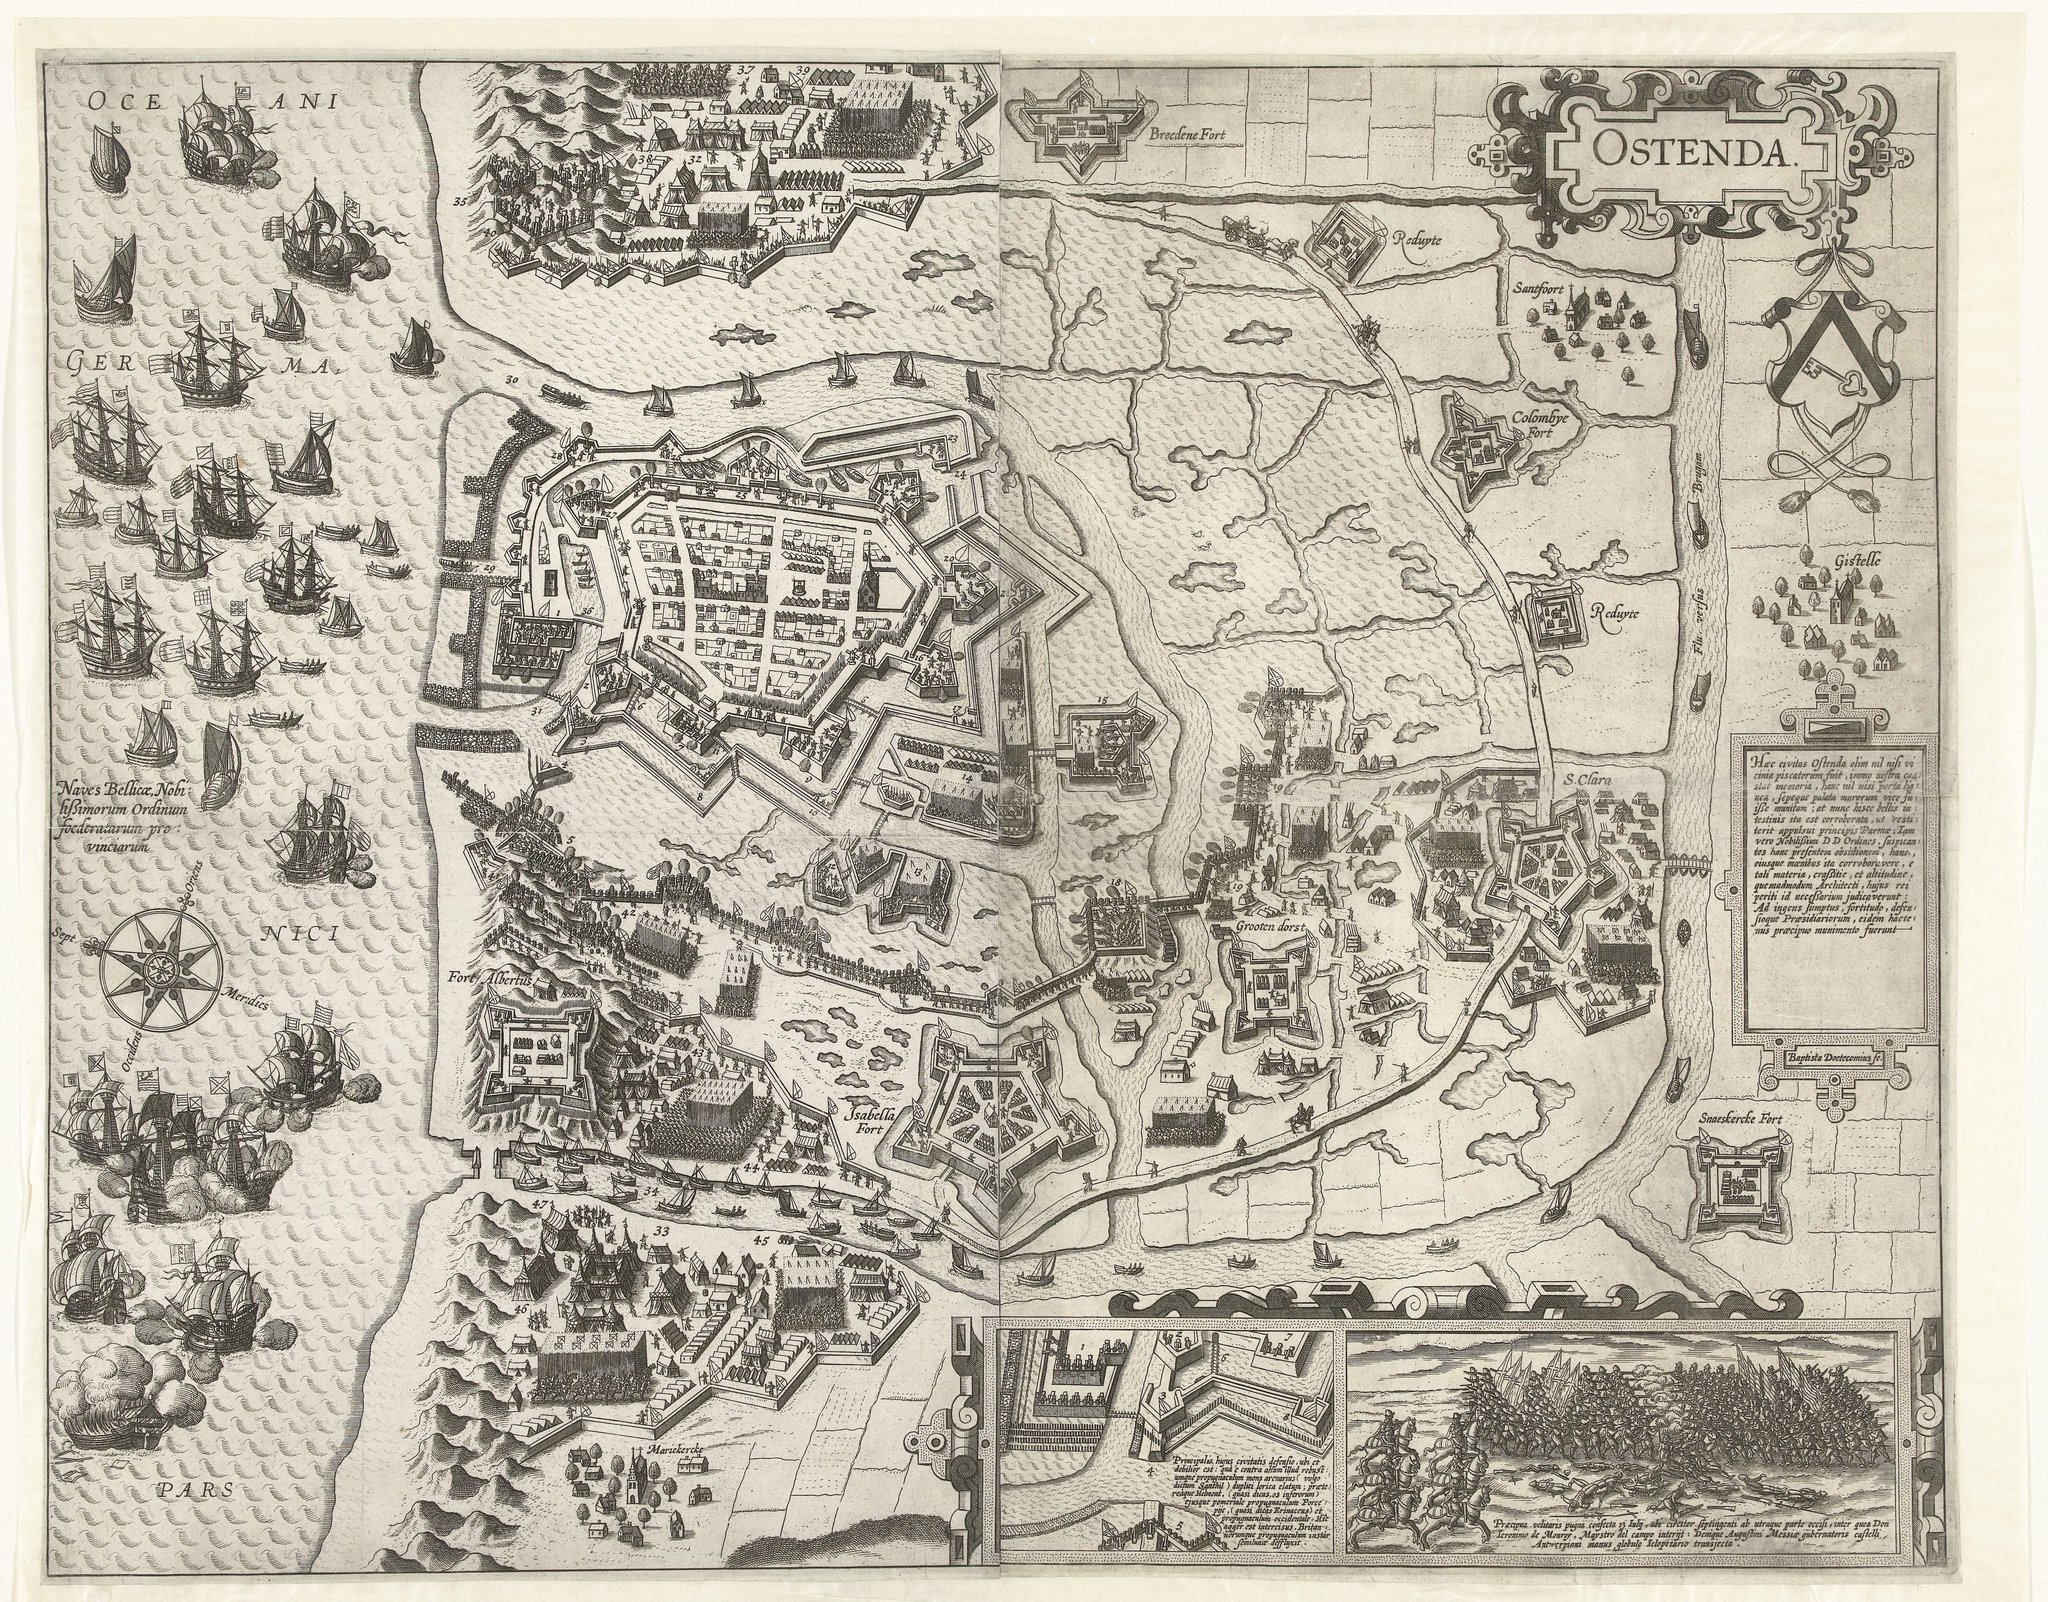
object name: print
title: Beleg van Oostende, 1601-1602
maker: baptista van doetechum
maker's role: print maker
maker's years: -1611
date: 1601-1602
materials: paper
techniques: etching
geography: northern netherlands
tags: brussels, albrecht aartshertog van oostenrijk, maps of separate countries or regions, siege, position war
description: Beleg van Oostende door de Spaanse troepen onder Albrecht in de jaren, 1601-1602. Kaart van de stad met de verdedigingswerken. Links beschieten schepen elkaar op de zee. Rechts een cartouche met een Latijnse tekst, de titel en het stadswapen; onderaan twee inzetten met een detail van een schans en het gevecht op 13 juli 1601 waarbij de Spaanse veldoverste De Monroy sneuvelde. Details in de voorstelling genummerd 1-47 (de legenda ontbreekt).